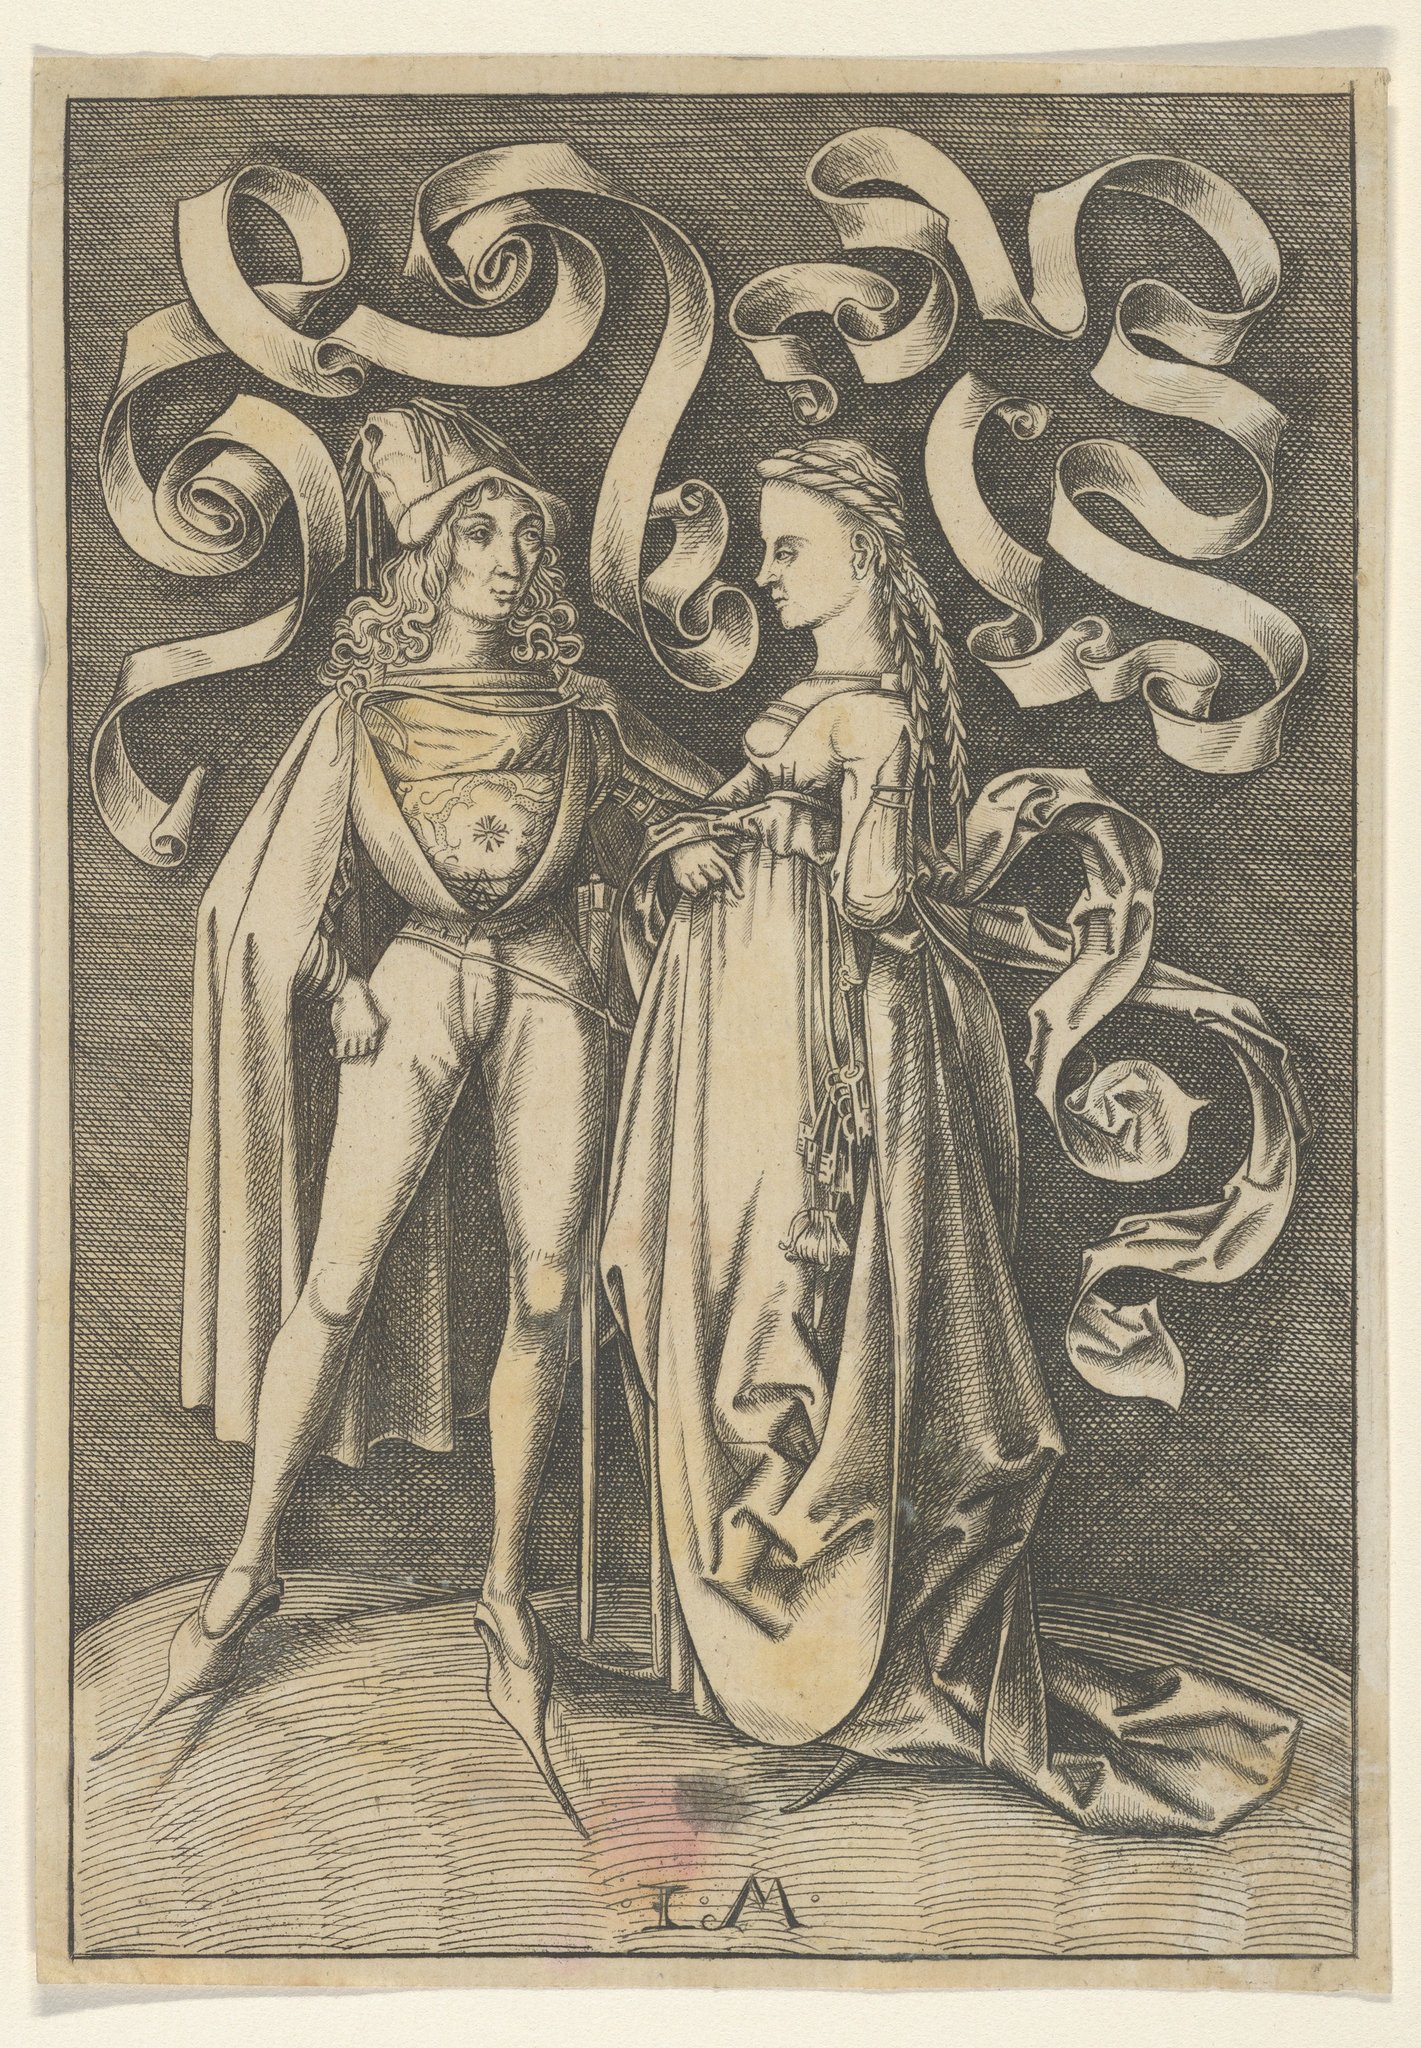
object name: print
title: The Knight and the Lady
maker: Anonymous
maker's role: artist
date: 1495-1550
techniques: engraving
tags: women,knights